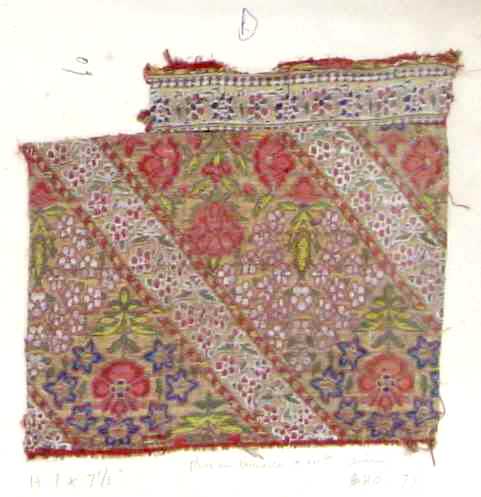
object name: textile fragment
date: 1601-1700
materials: metal thread, silk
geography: iran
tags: flowers